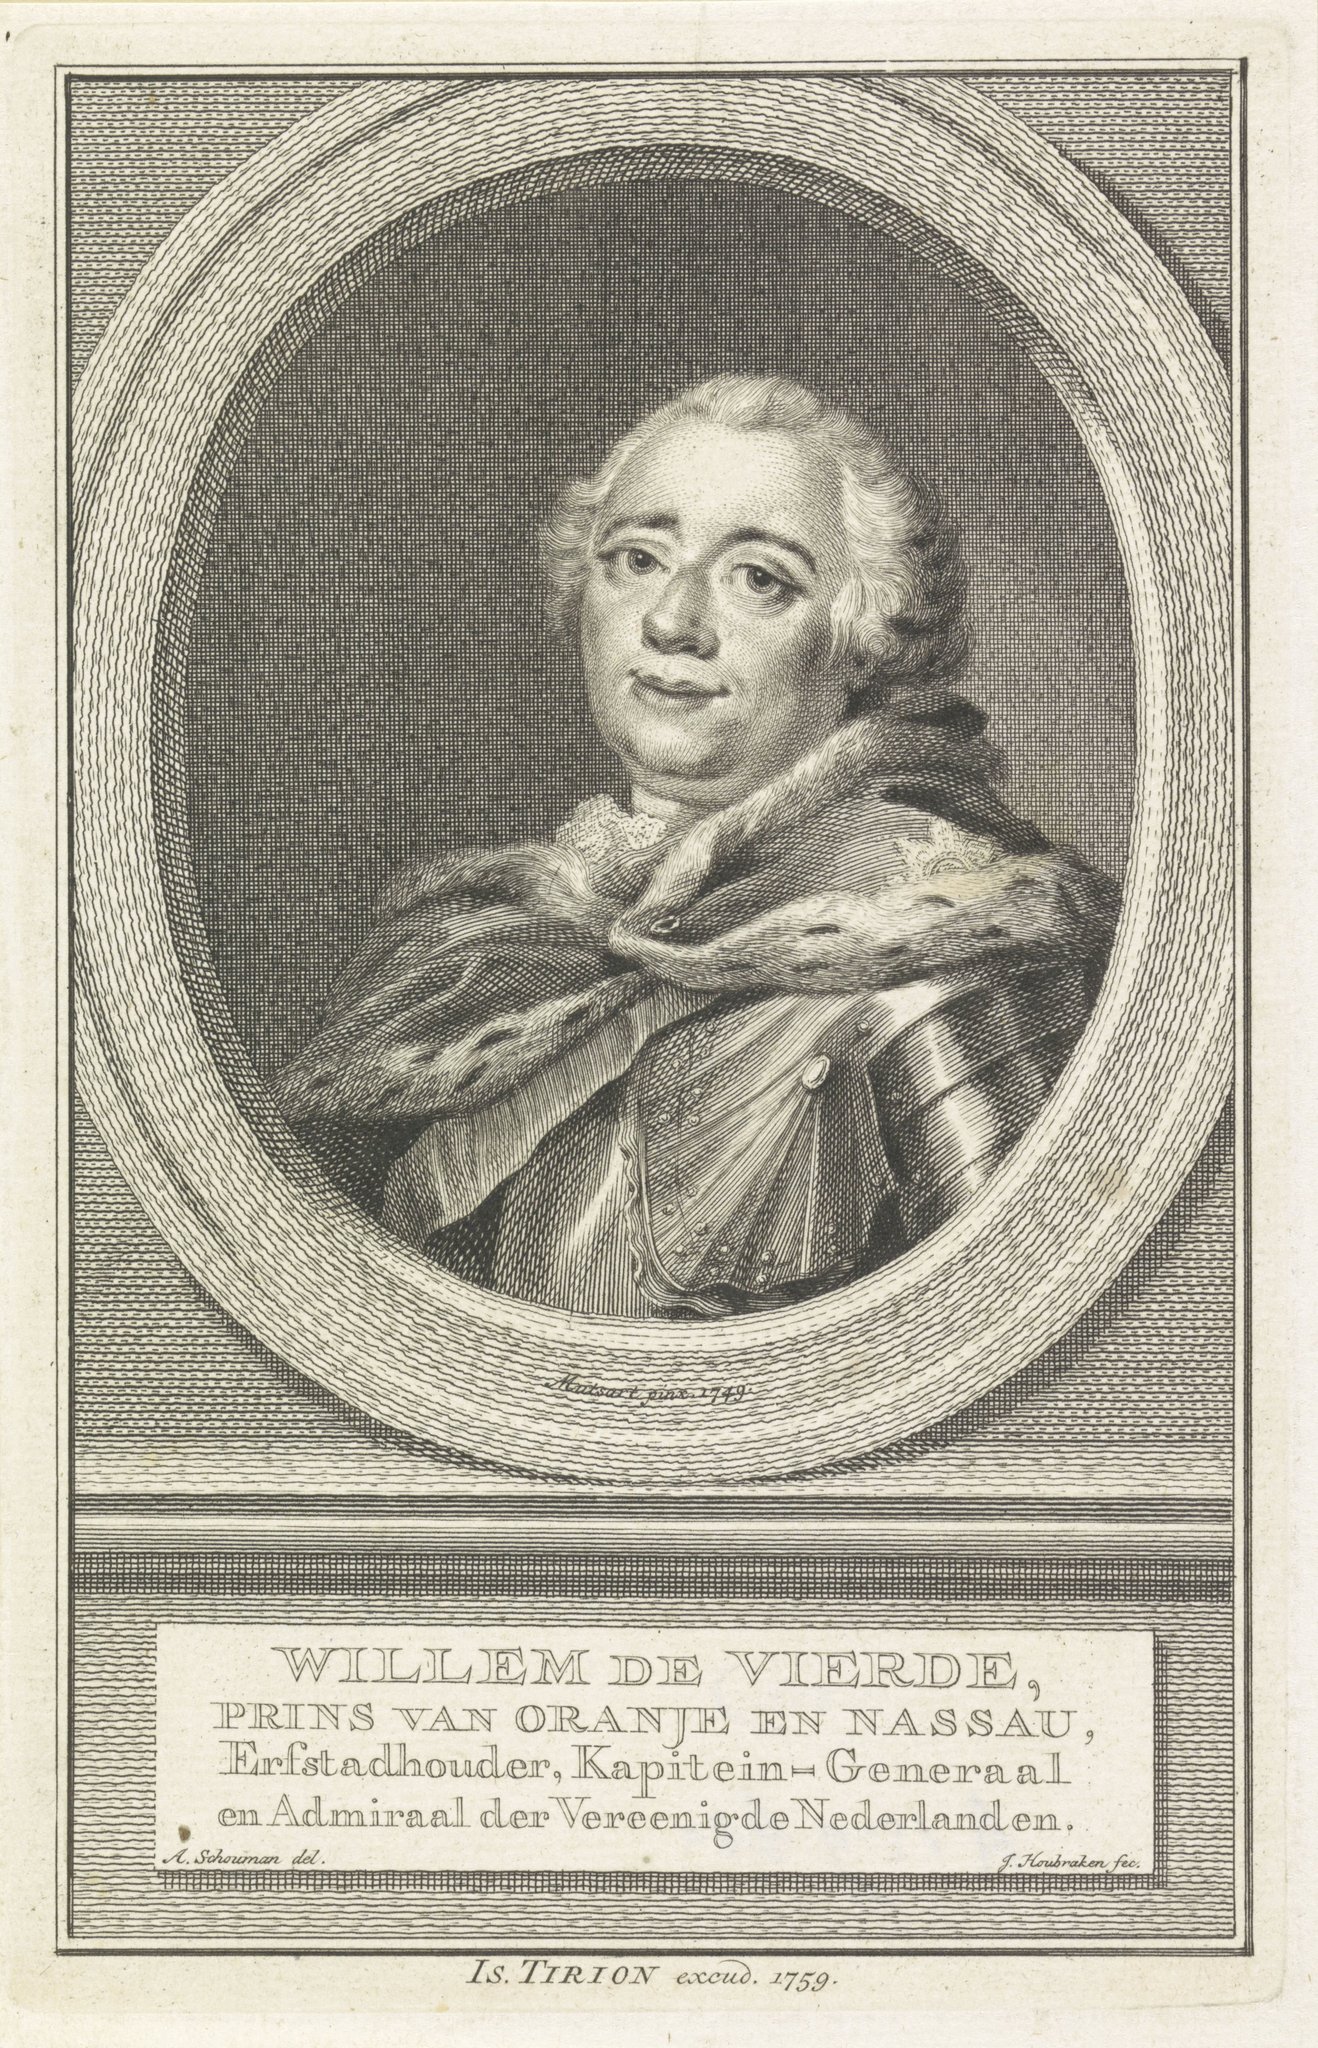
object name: print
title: Portret van Willem IV, prins van Oranje-Nassau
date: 1749-1759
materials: paper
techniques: engraving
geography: amsterdam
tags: willem iv (prins van oranje-nassau)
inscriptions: collector's mark: Lugt 2228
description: De hier vermelde titel verwijst naar de hoogst verkregen titel van de geportretteerde, niet per se naar de titel die de geportretteerde op deze voorstelling draagt. Prent uit: Wagenaar, Jan. Vaderlandsche historie. Amsterdam: Isaak Tirion, 1749-1759.